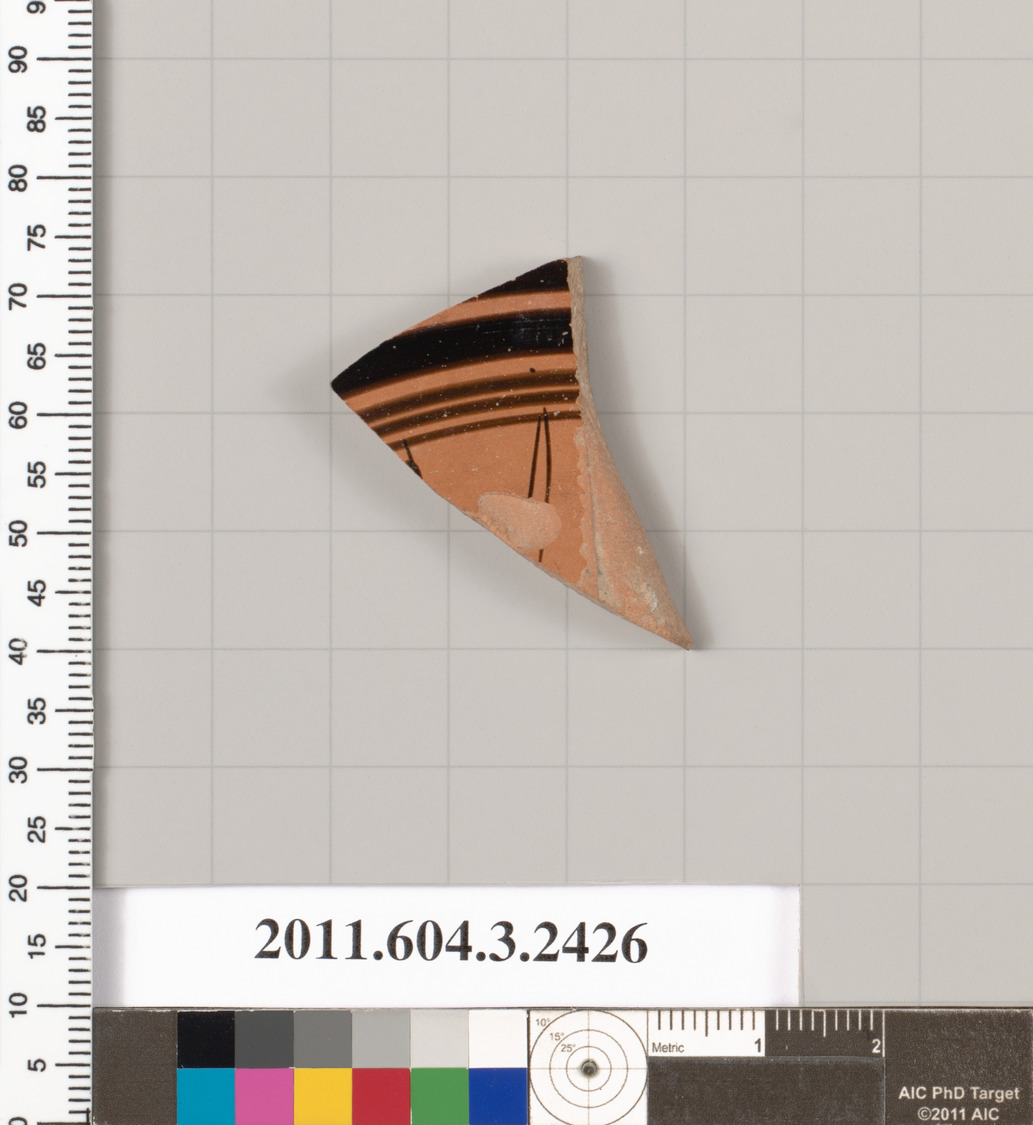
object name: kylix fragment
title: Terracotta fragment of a kylix: eye-cup (drinking cup)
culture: greek, attic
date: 530-520 BCE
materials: terracotta